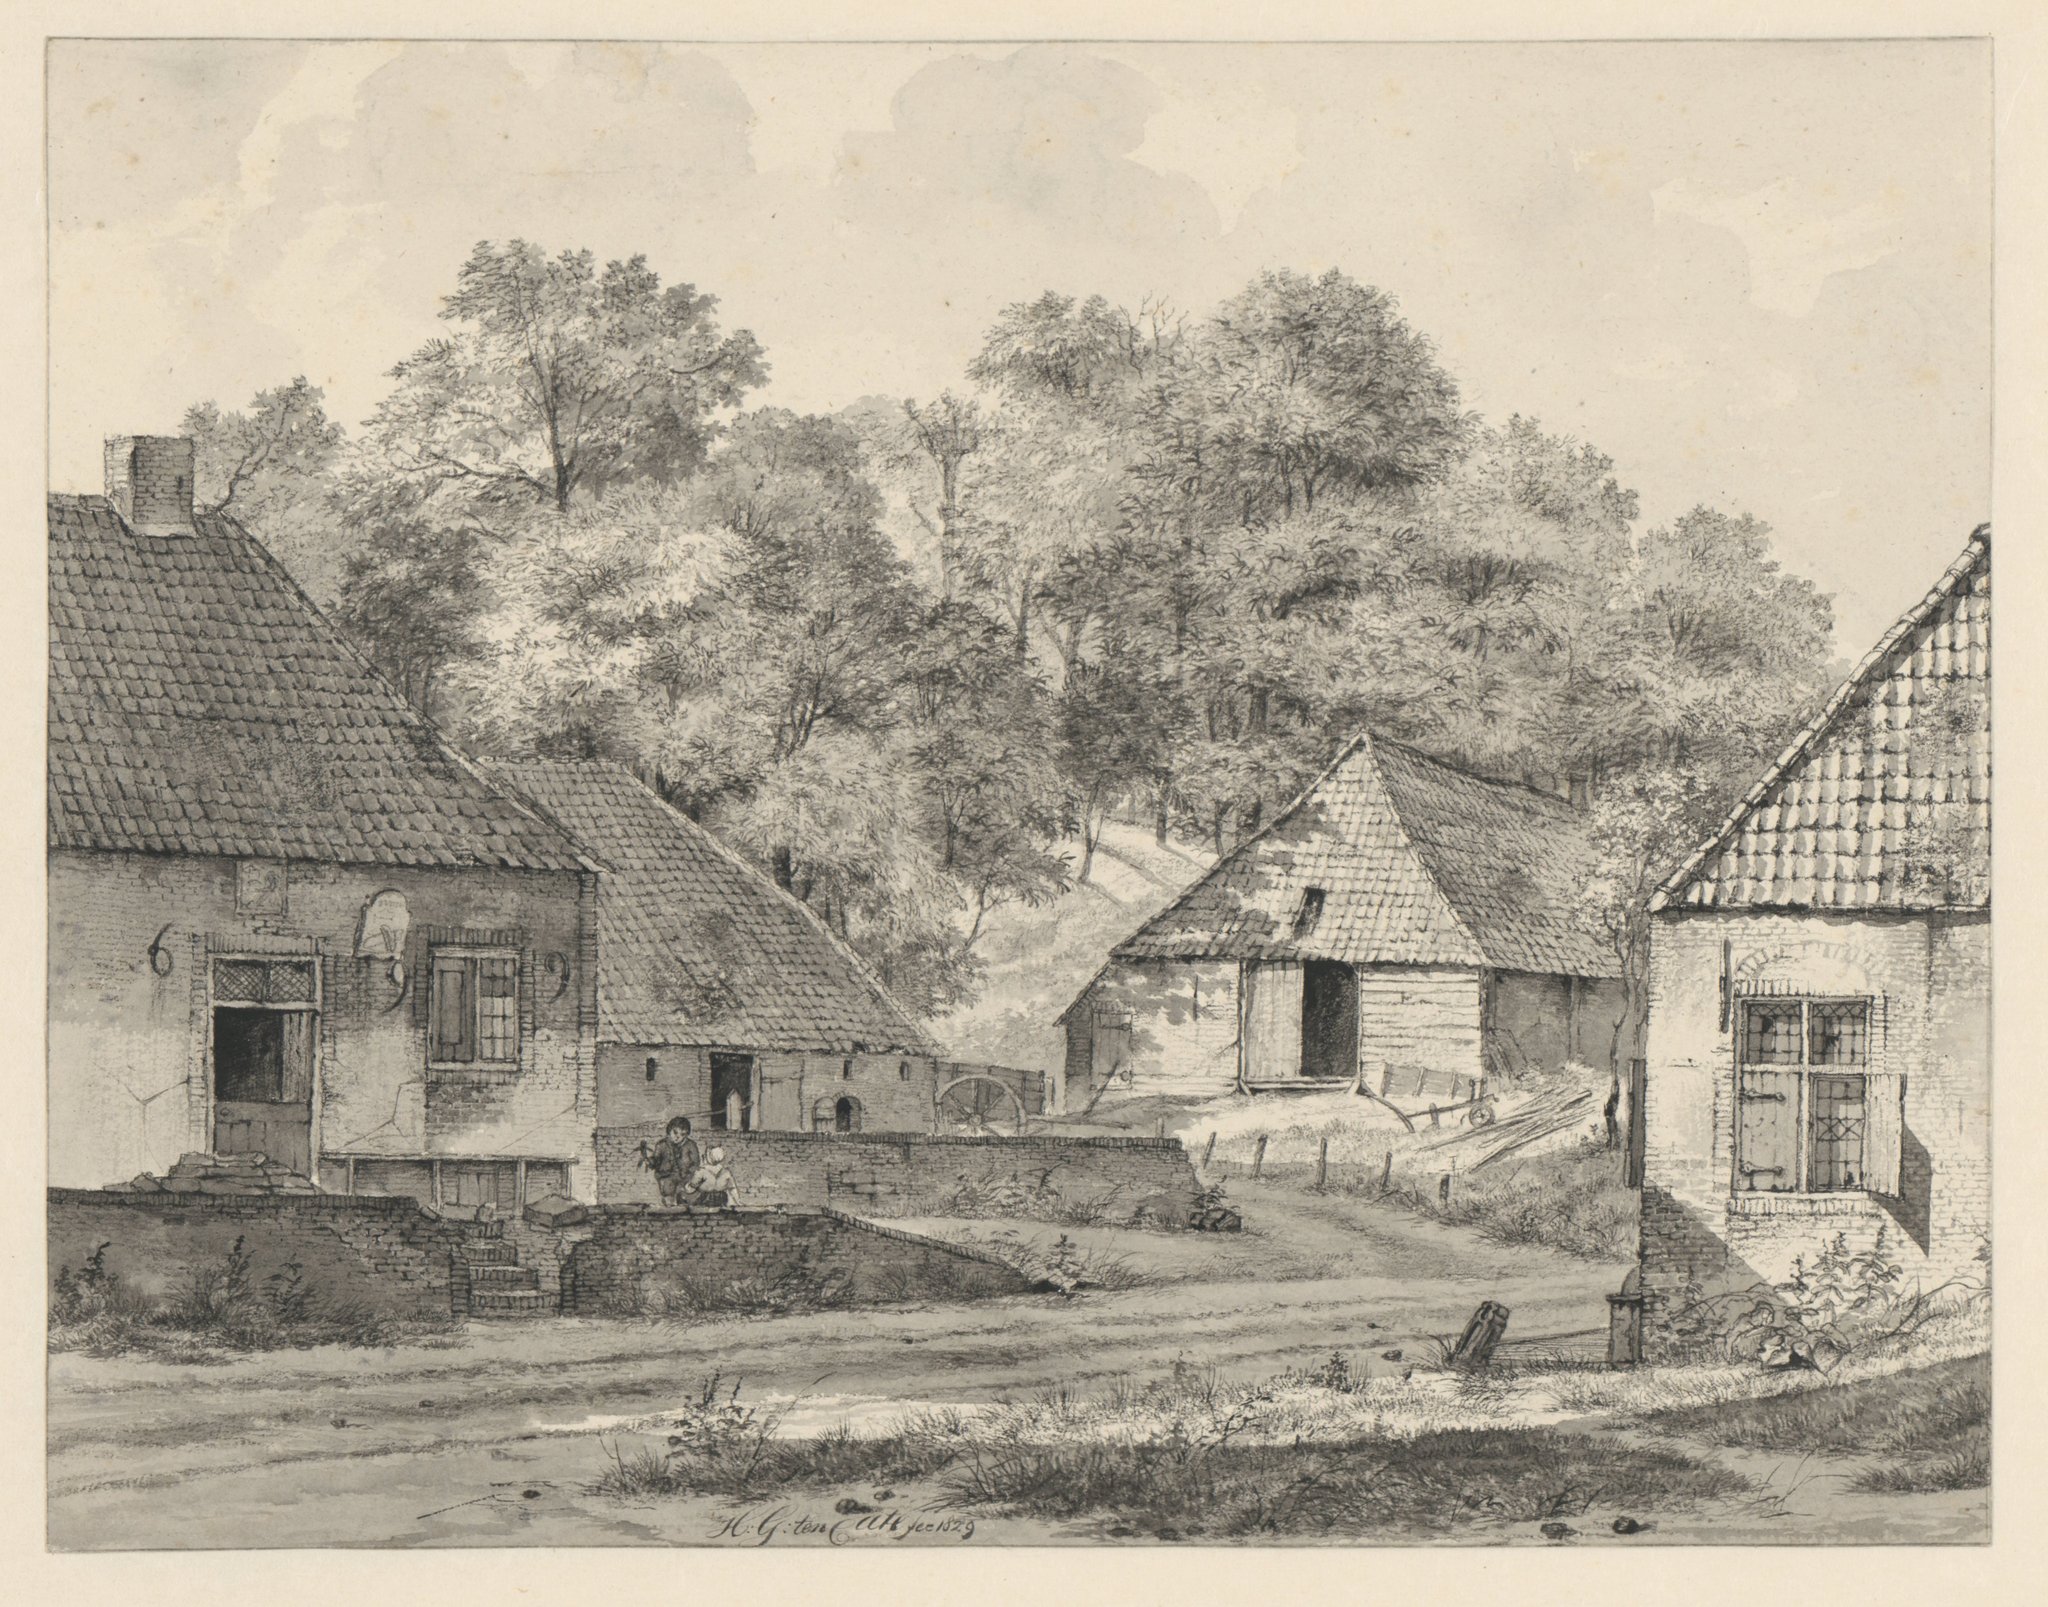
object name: drawing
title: Boerderijen te Beek, boven Nijmegen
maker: hendrik gerrit ten cate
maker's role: draughtsman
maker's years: 1803-1856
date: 1829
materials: chalk, paper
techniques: brush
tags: farm (building)